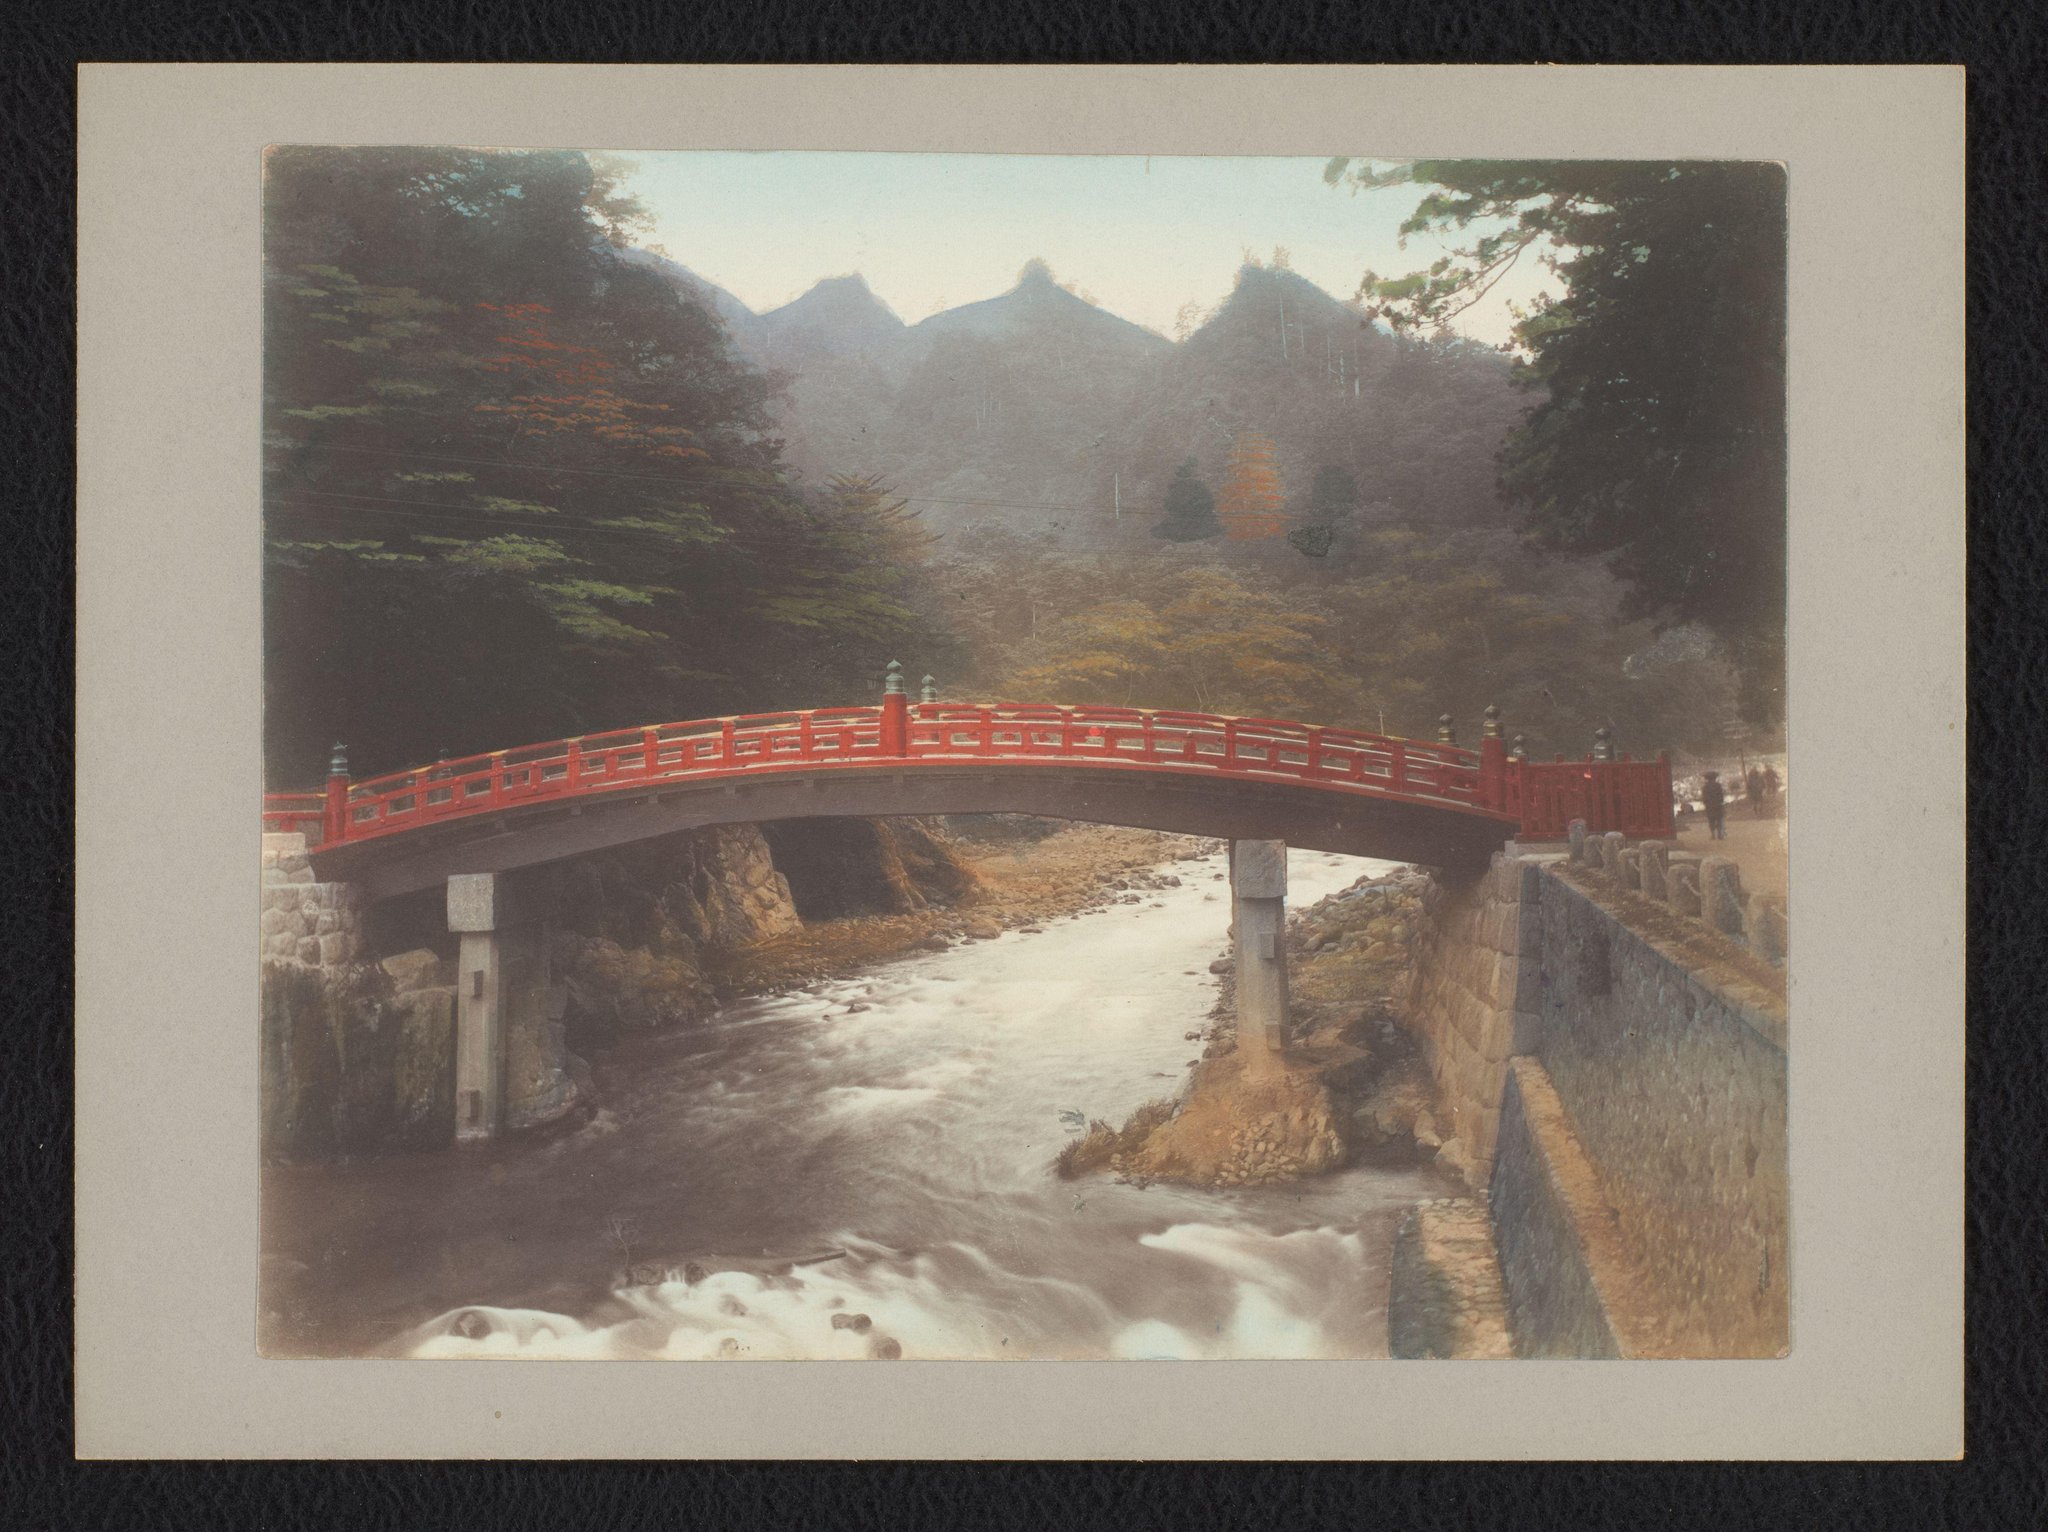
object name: photograph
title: Heilige brug, Japan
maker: Anonymous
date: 1895-1915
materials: cardboard, photographic support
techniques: salted paper print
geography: japan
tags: japan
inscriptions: annotation: ‘27. Sacred bridge.’